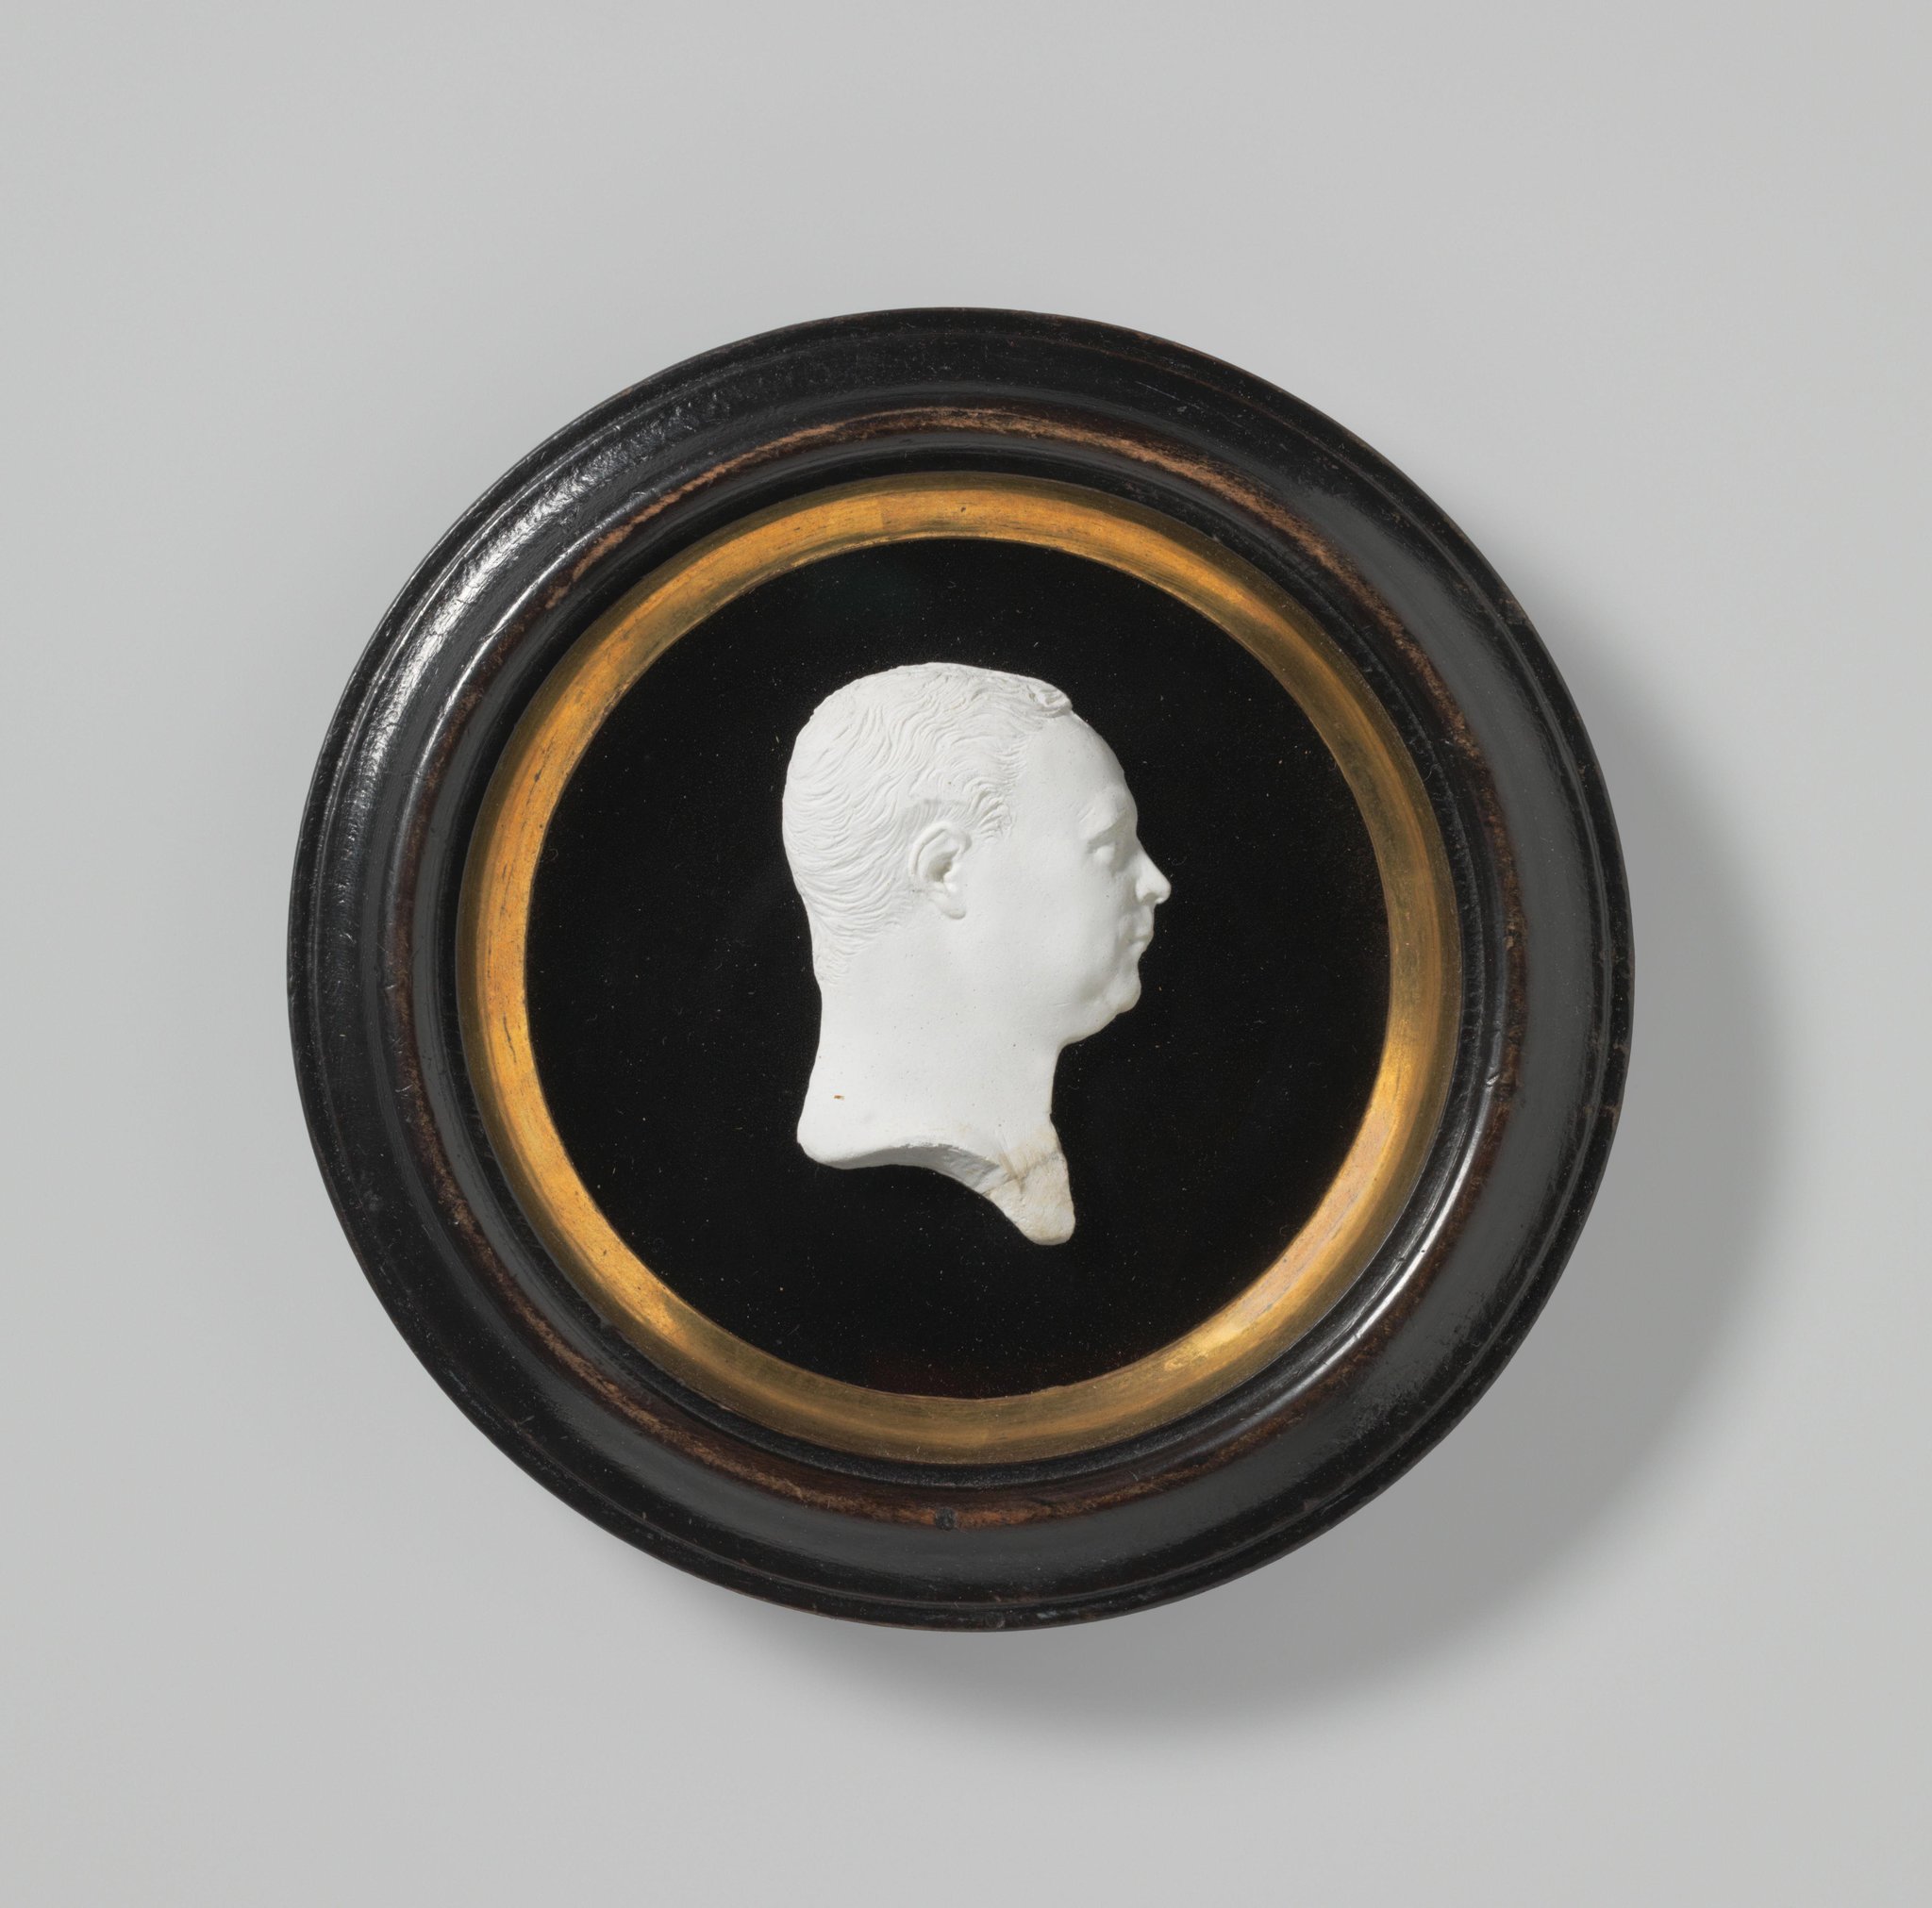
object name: relief sculpture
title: Cornelis Ploos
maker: Anonymous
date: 1750-1825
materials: gypsum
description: Reliëf van gips. Portret van Cornelis Ploos en profil afgebeeld. Geplaatst in een ronde zwart houten lijst met goudkleurige binnenrand.